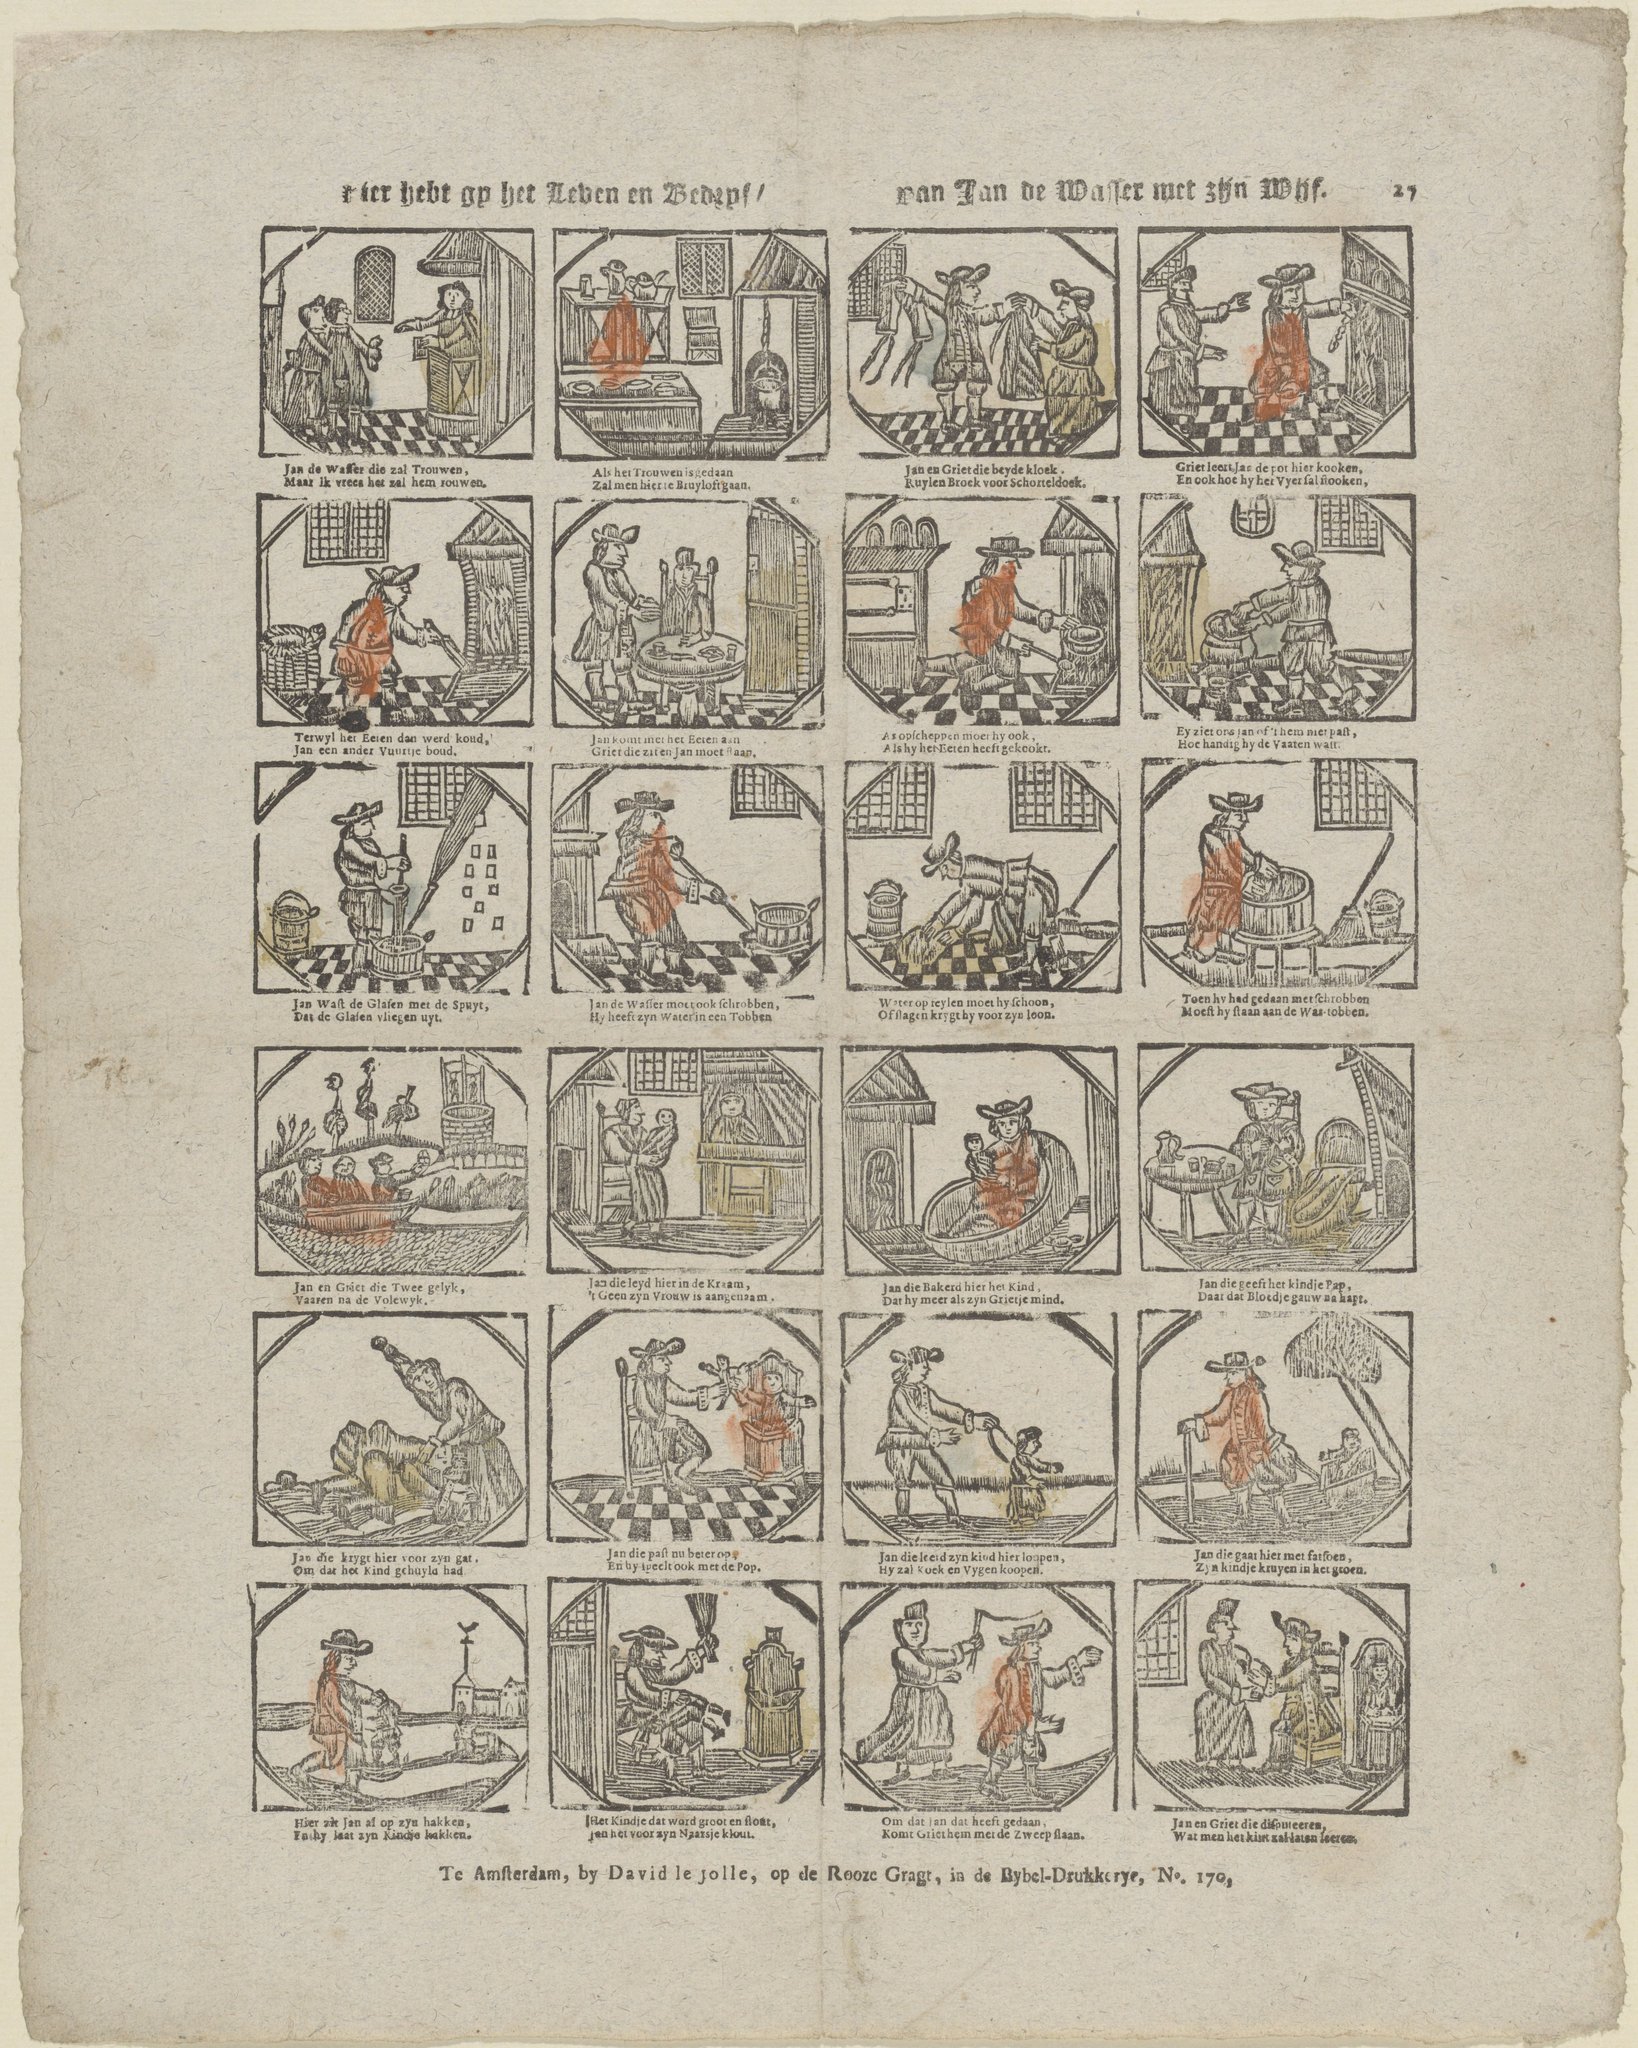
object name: print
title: Hier hebt gy het leven en bedryf / Van Jan de Wasser met zyn wyf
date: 1814-1820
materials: paper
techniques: colour, letterpress printing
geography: netherlands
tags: hen-pecked husband, 'betty', 'molly' (man who engages in women's work)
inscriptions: collector's mark: Lugt 2760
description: Blad met 24 voorstellingen uit het leven van Jan de Wasser, een man die van zijn vrouw Griet, die de broek aan heeft, al het huishoudelijk werk moet doen. Onder elke afbeelding een tweeregelig vers. Genummerd rechtsboven: 27.